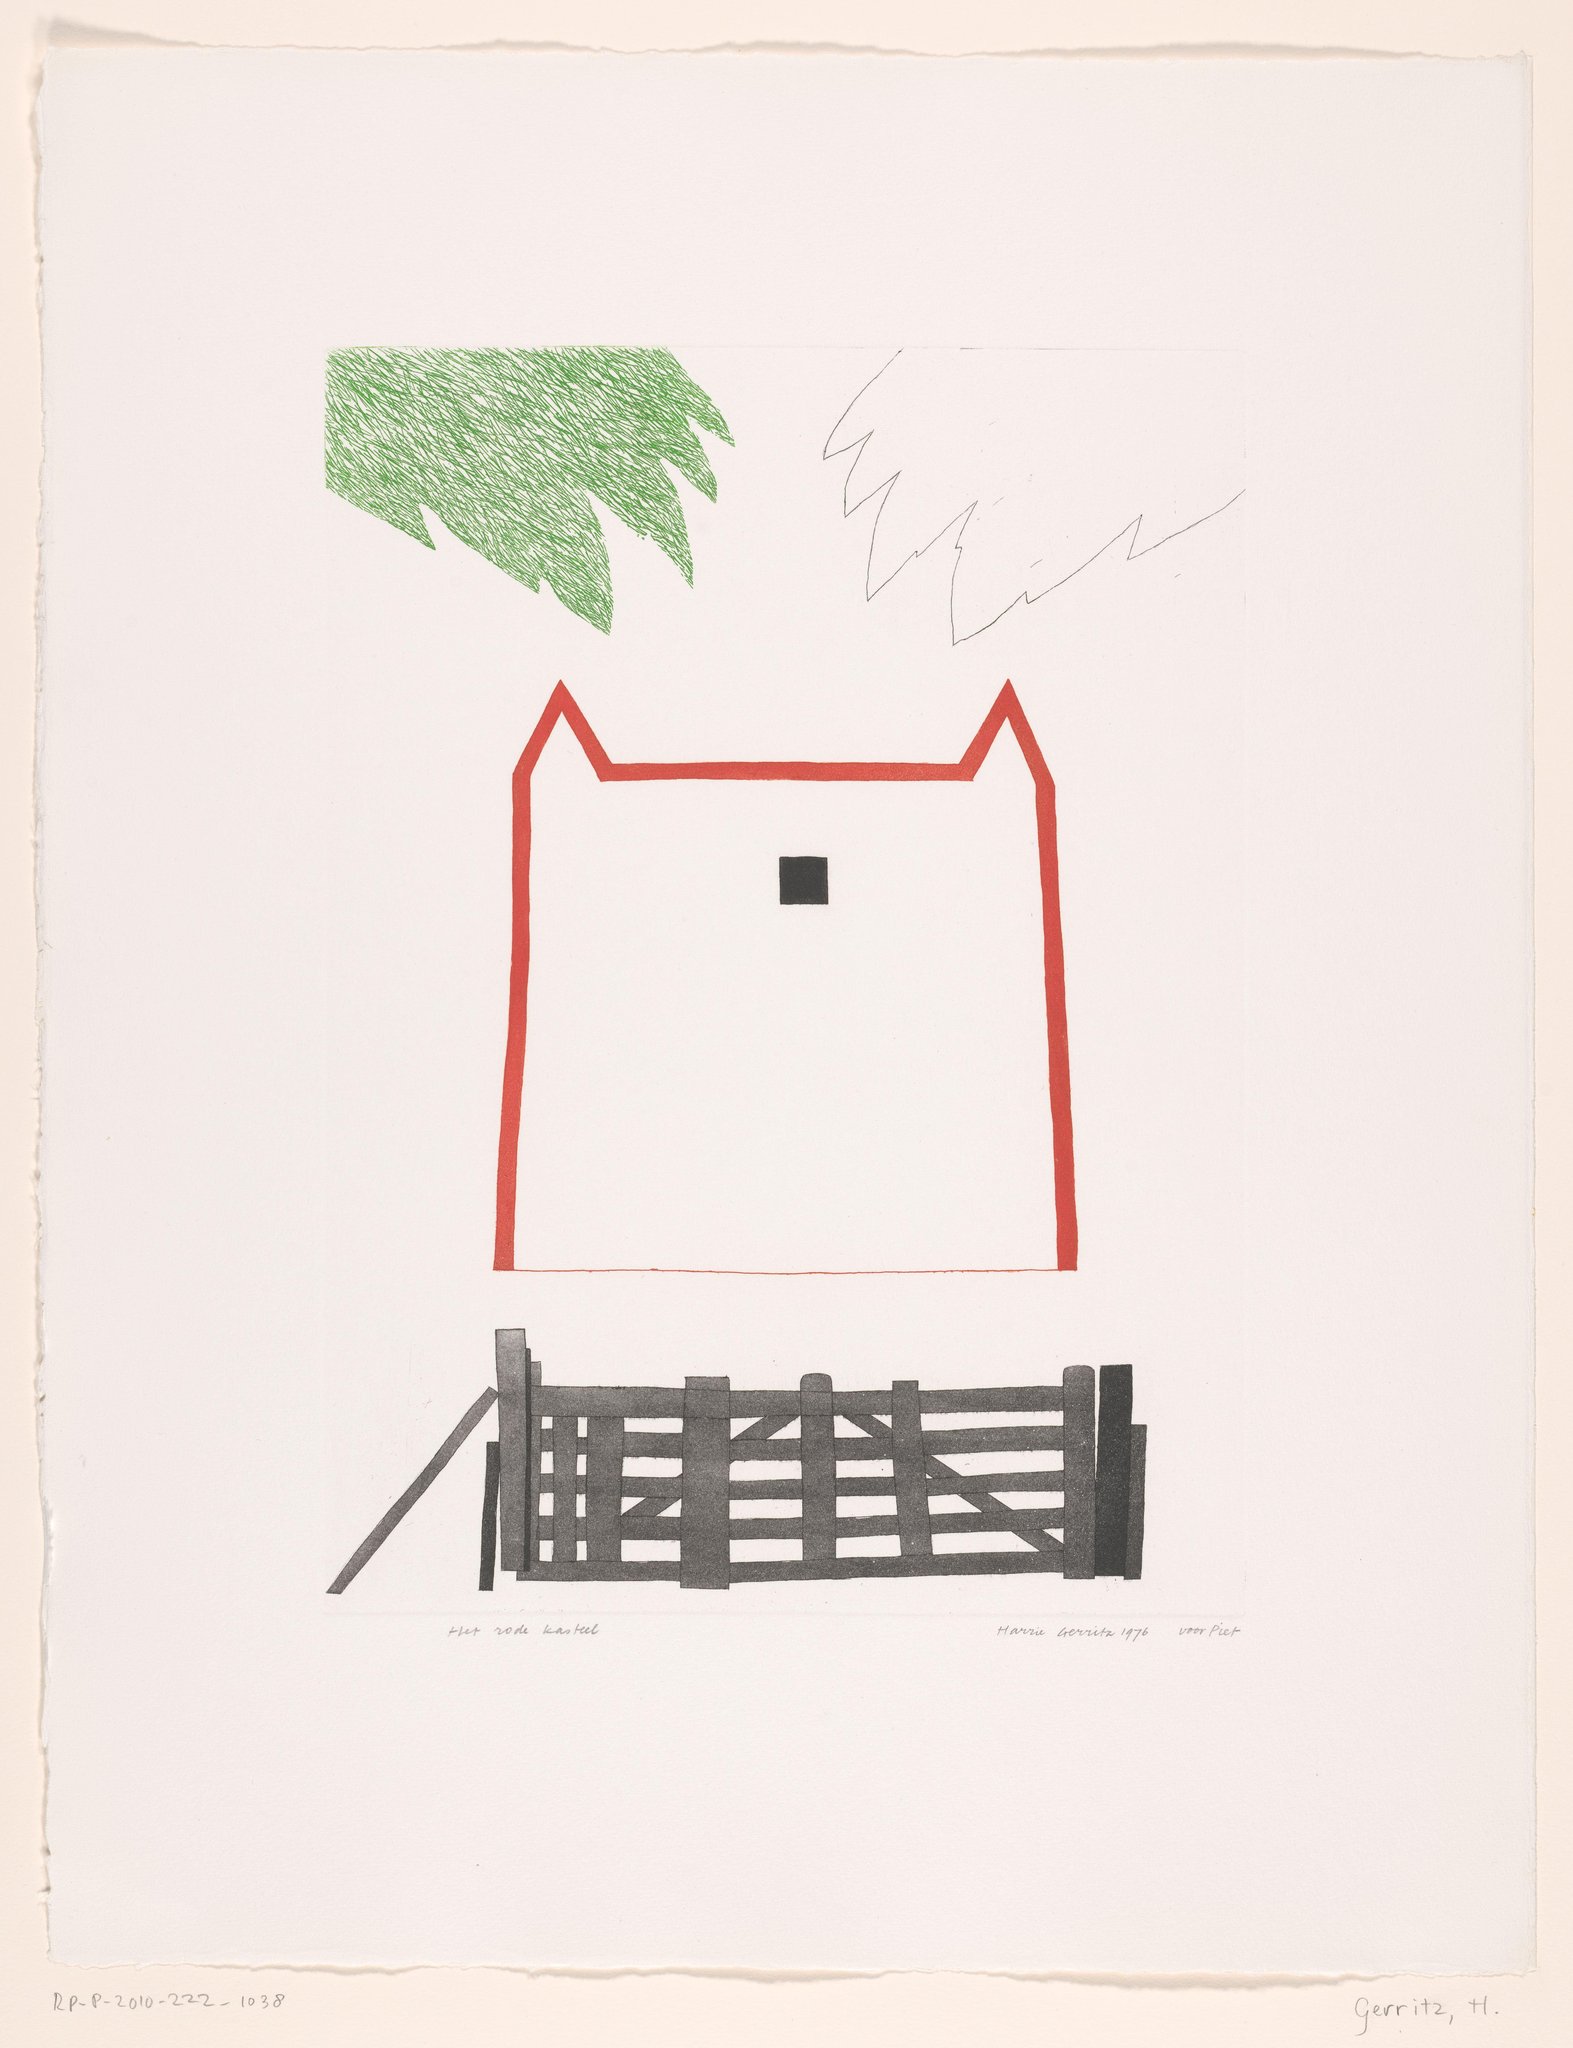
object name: print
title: Het rode kasteel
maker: harrie a. gerritz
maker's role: draughtsman, painter, print maker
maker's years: 1940-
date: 1976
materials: paper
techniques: aquatint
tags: castle, receiver, fence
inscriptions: inscription: ‘Shirley’, collector's mark: Lugt 2228, dedication: ‘voor Piet’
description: Rode omtrek van een kasteel met in het midden een zwart raam, op de voorgrond een hek.